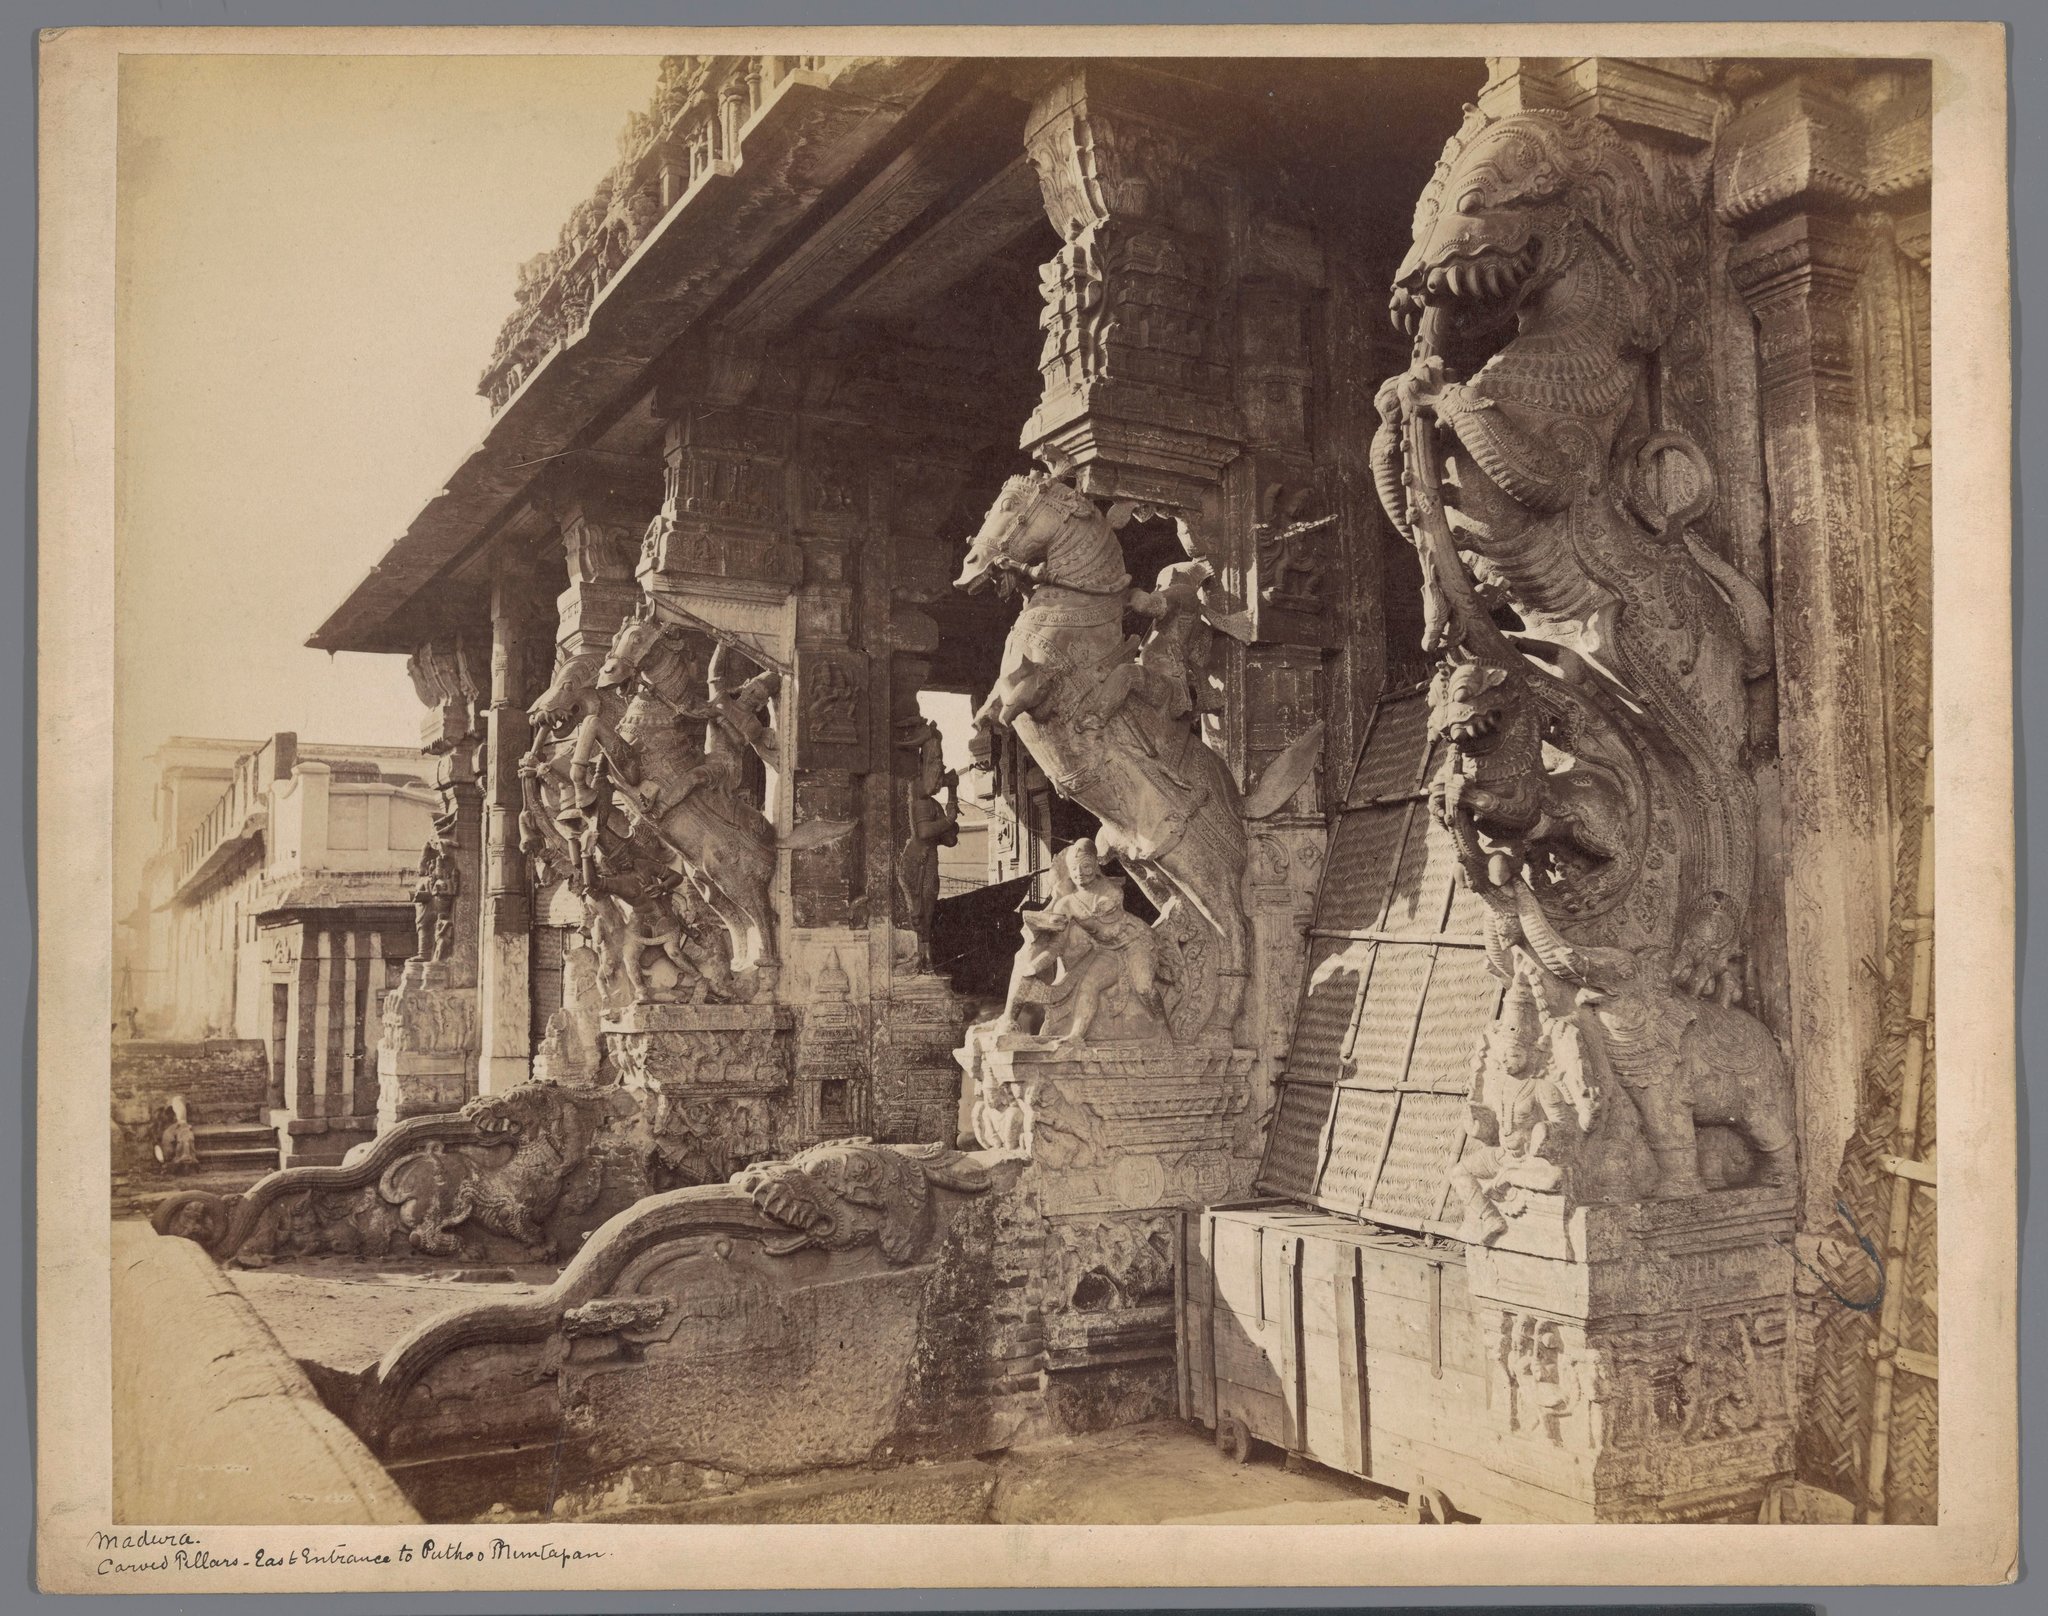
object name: photograph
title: Carved pillars of the Meenakshi temple in Madurai, Tamil Nadu, India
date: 1878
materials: cardboard, paper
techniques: albumen print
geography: madurai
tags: temple, shrine ~ hinduism, buddhism, jainism, column, pillar ~ architecture, piece of sculpture, reproduction of a piece of sculpture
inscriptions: number: ‘1’, title: ‘Madura./ Carved Pillars - East Entrance to Puthoo Muntapan.’